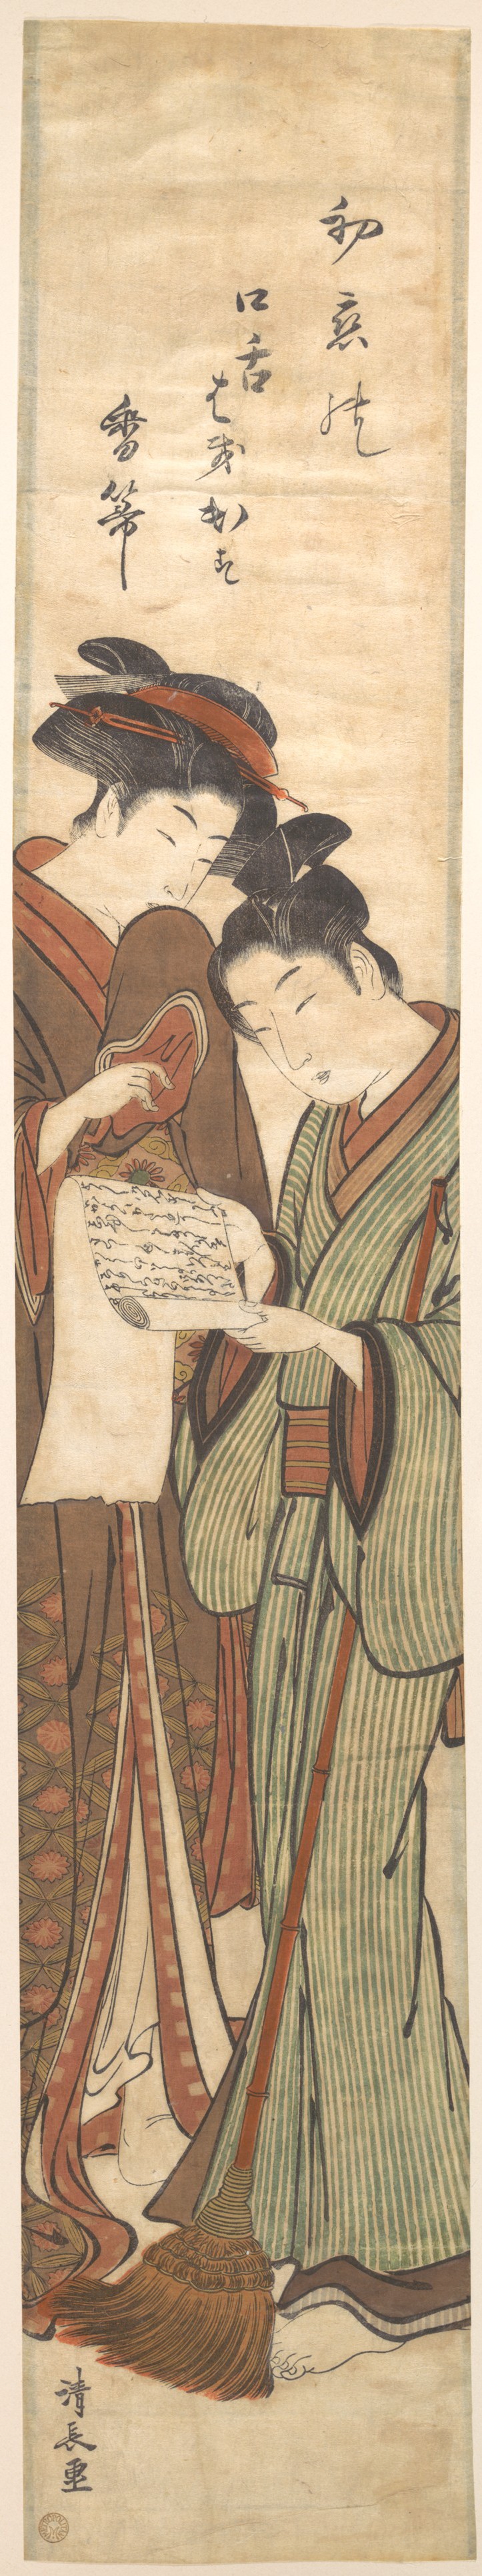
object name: print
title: The Idle Broom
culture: japanese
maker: torii kiyonaga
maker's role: artist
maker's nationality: japanese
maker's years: 1752-1815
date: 1780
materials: ink, paper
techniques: woodblock print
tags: men,women,reading,brooms